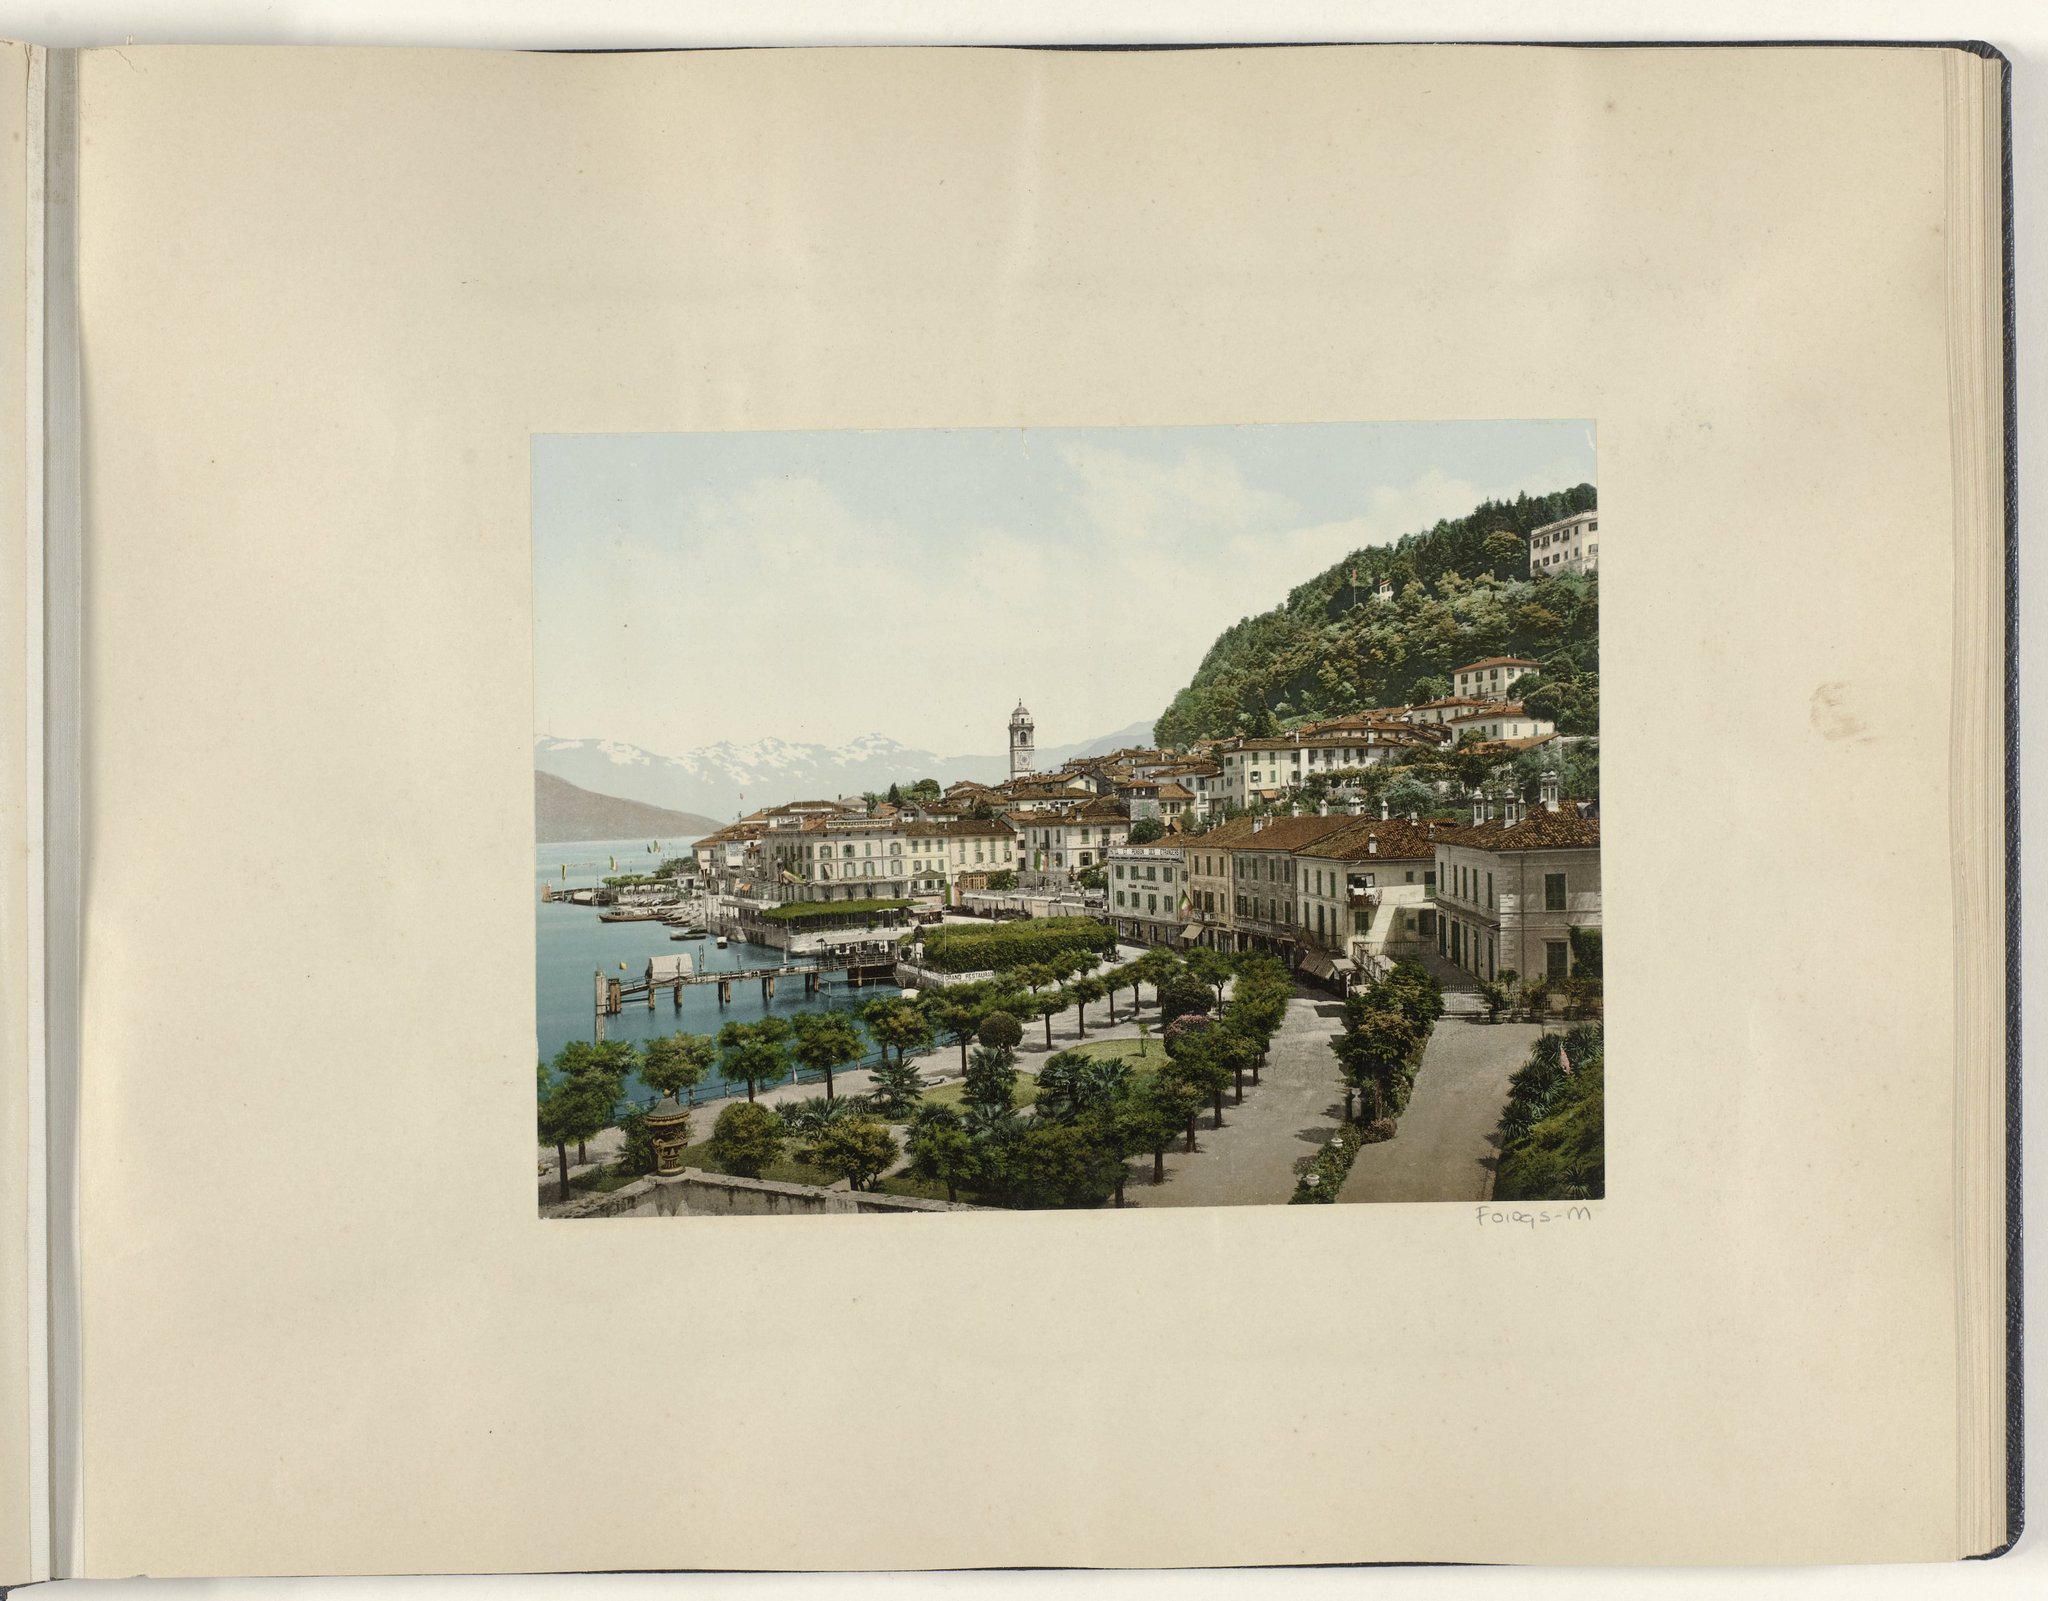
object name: photograph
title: Bellagio.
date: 1880-1900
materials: paper, photographic process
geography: bellagio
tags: prospect of city, town panorama, silhouette of city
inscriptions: number: ‘16604’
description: Onderdeel van Reisalbum met foto's van bezienswaardigheden in Italië, Zwitserland en Nederlands-Indië.